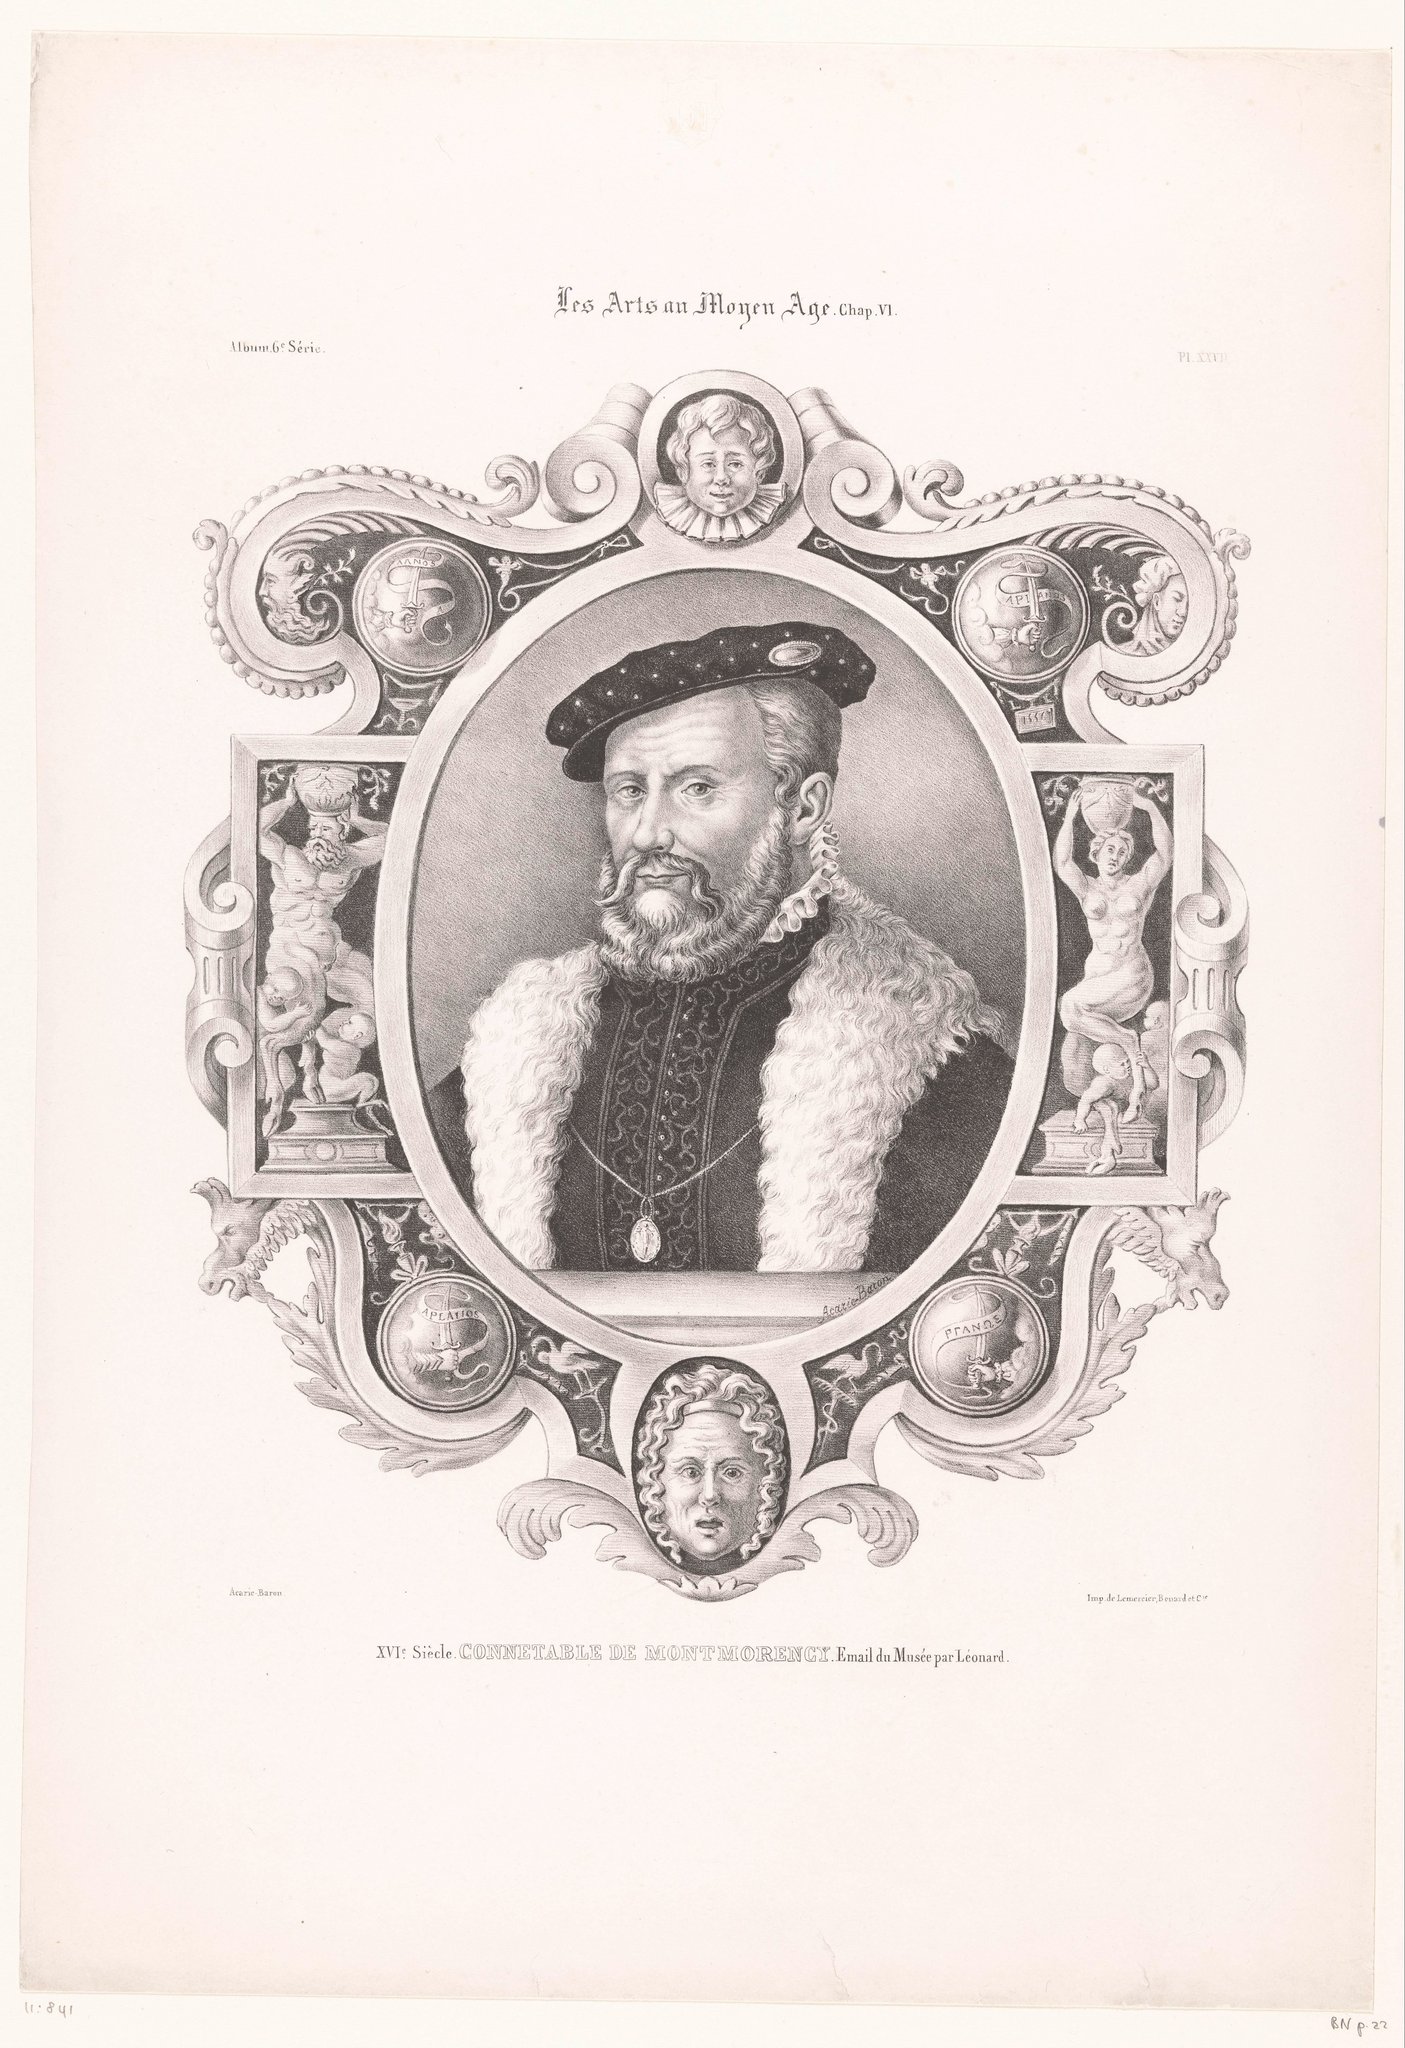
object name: print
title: Portret van Anne de Montmorency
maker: jacques reyne isidore acarie-baron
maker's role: draughtsman, print maker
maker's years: 1798-1874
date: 1838-1846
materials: paper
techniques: lithograph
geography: paris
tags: chantilly, historical persons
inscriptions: inscription: ‘Album 6e Série. Pl. XXVII.’, collector's mark: Lugt 2228, stamp: Lugt 105b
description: Prent uitgegeven bij: Sommerard, Alexandre du. Les arts au Moyen Age. En ce qui concerne principalement le Palais Romain de Paris, l'Hotel de Cluun (…). 5 dln. Parijs: s.n., 1838-1846. De volledige uitgave van 'Les arts au Moyen Age' bestond uit de vijf hierboven genoemde boeken met tekst en daarbij horende prenten die los van de tekst zijn uitgegeven. De prenten zijn verdeeld onder 'L'Atlas' en 'L'Album'. 'L'Album' is onderverdeeld in tien delen met ieder 40 prenten, de huidige prent hoort bij het zesde deel. Het serienummer verwijst dus naar het nummer van deze prent binnen de 40 prenten van dat deel. In sommige gevallen is het serienummer aangepast en komt het nummer op de prent niet overeen met het nummer in het hieronder vermelde overzicht. Voor de precieze inhoud van het tekstgedeelte, 'L'Atlas' en 'L'Album', zie: Sommerard, Alexandre du. Les arts au Moyen Age. En ce qui concerne principalement le Palais Romain de Paris, l’Hotel de Cluun (…). 5 dln. Parijs: s.n., 1838-1846, dl. 5 (1846) p. 379-429.